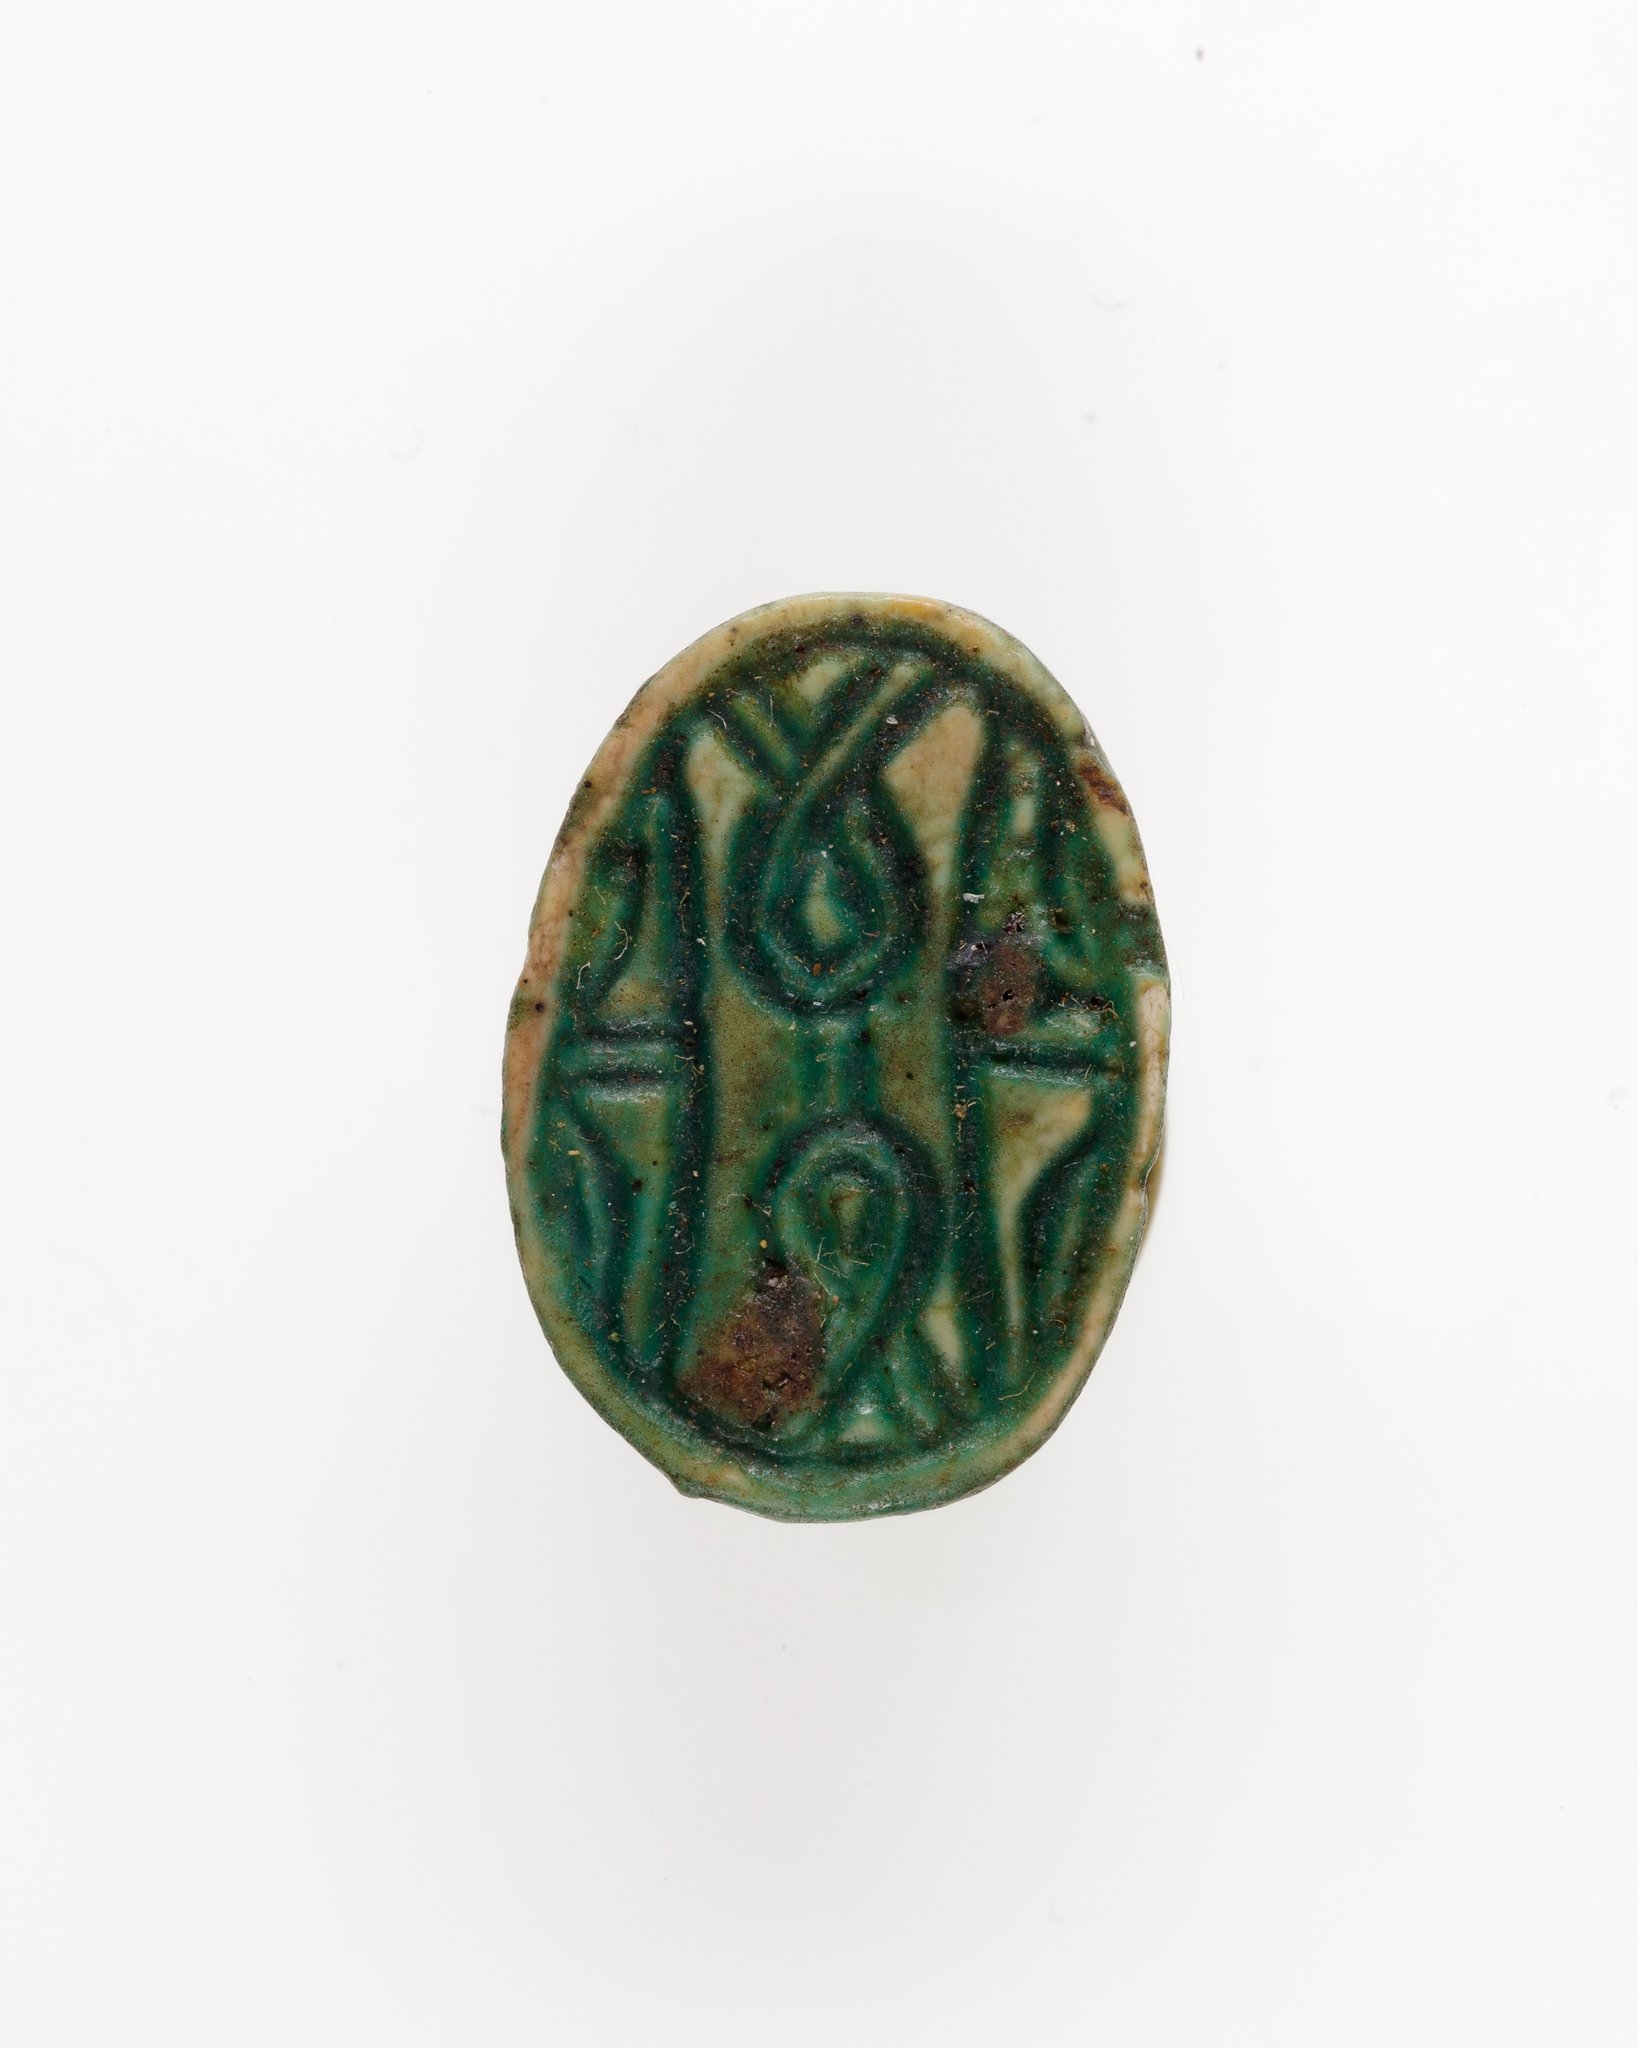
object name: scarab, loop, panel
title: Scarab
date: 1640-1550 BCE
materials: stone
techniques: glazing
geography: egypt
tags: scarabs